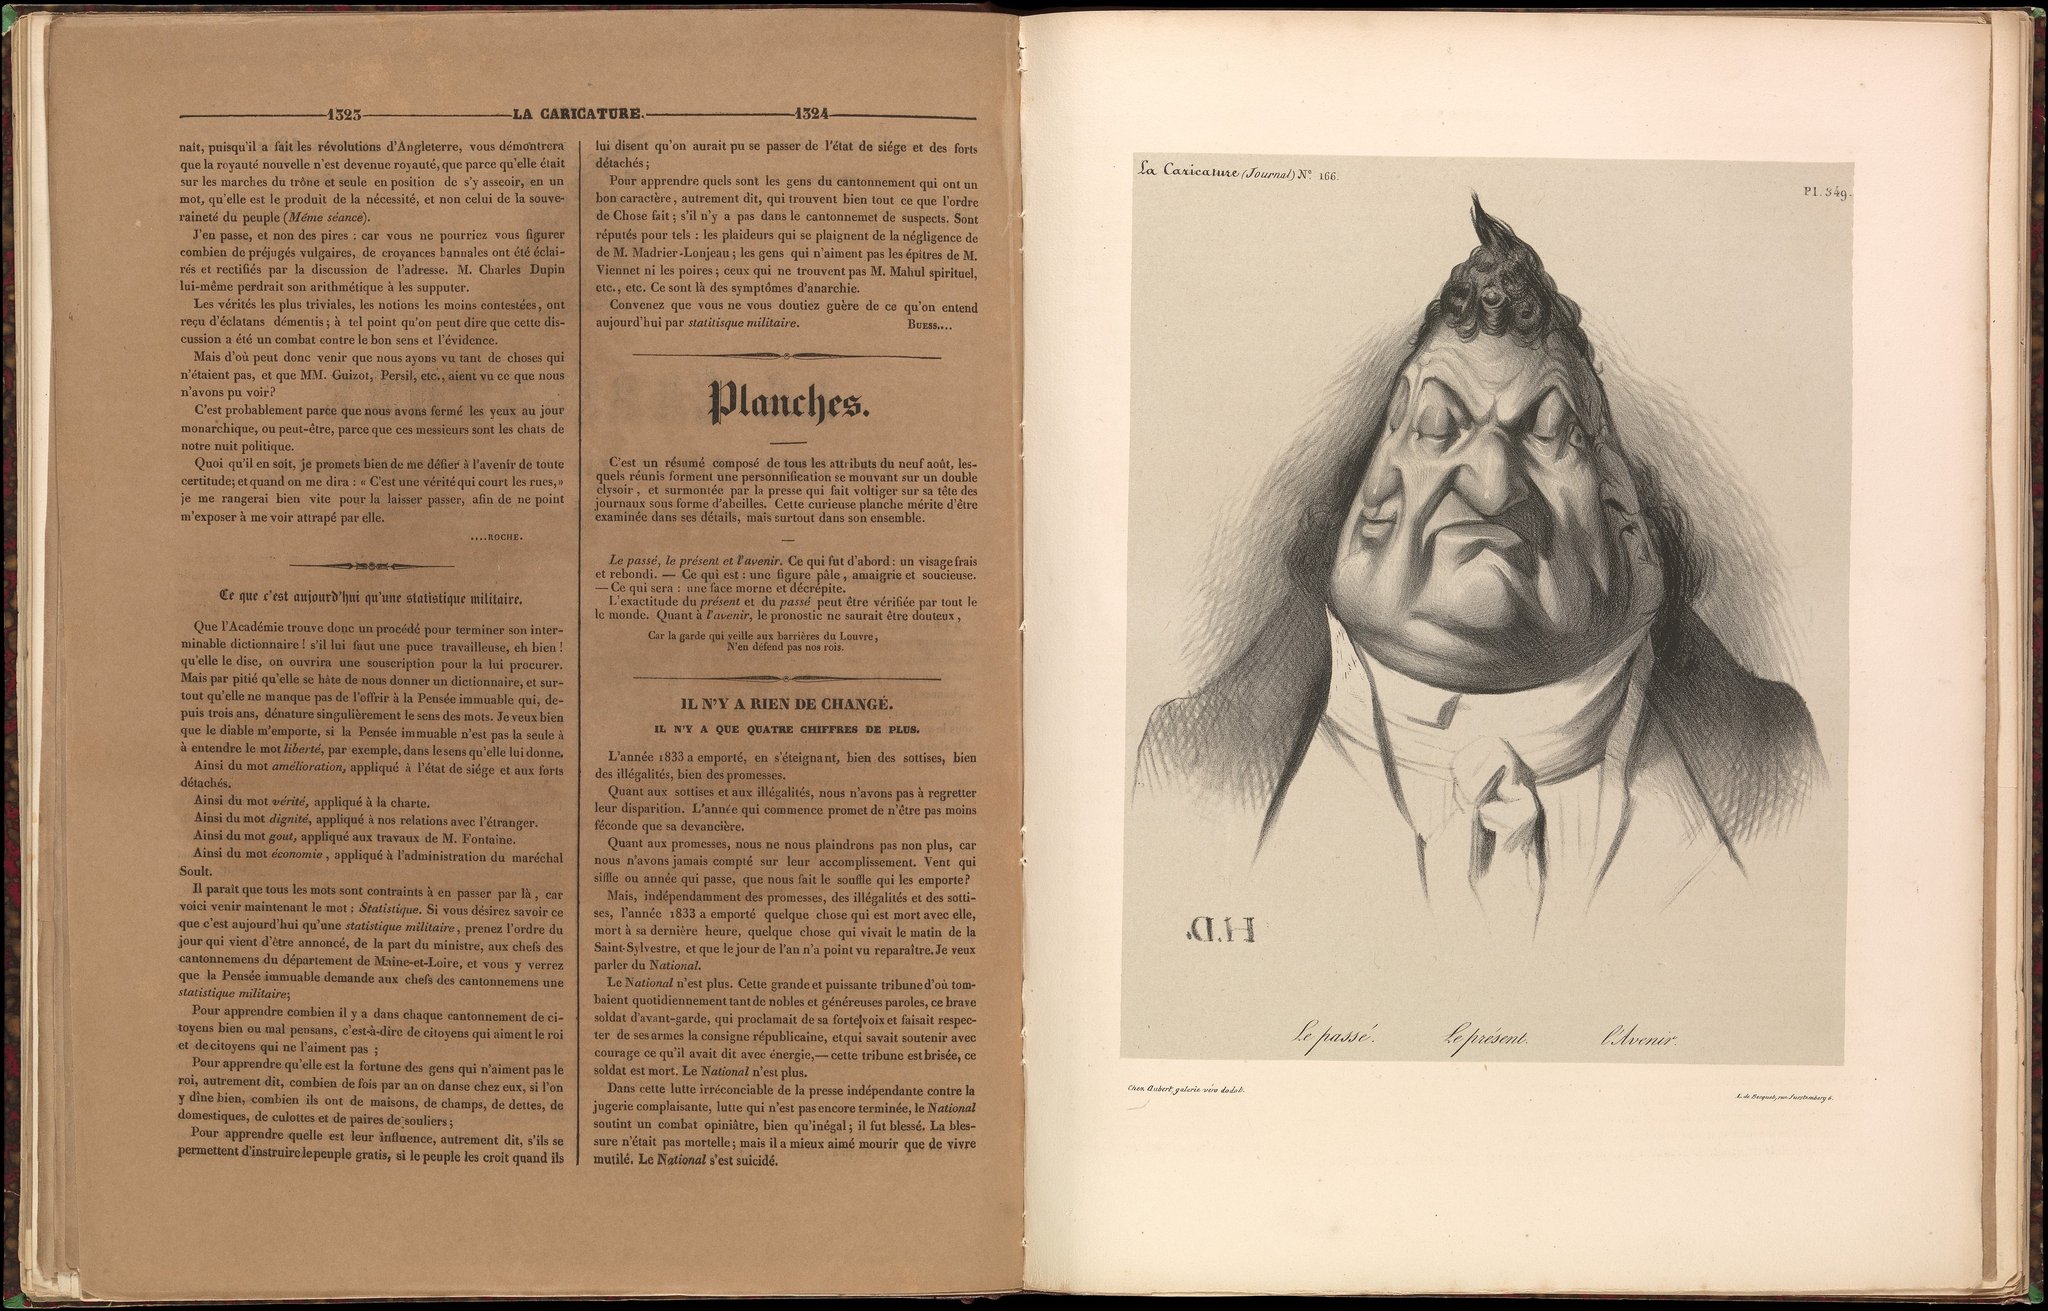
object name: print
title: The Past. The Present. The Future (Le passé. Le présent. L'avenir), from La Caricature, plate 349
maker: honoré daumier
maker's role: artist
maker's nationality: french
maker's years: 1808-1879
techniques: lithograph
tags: men,caricature